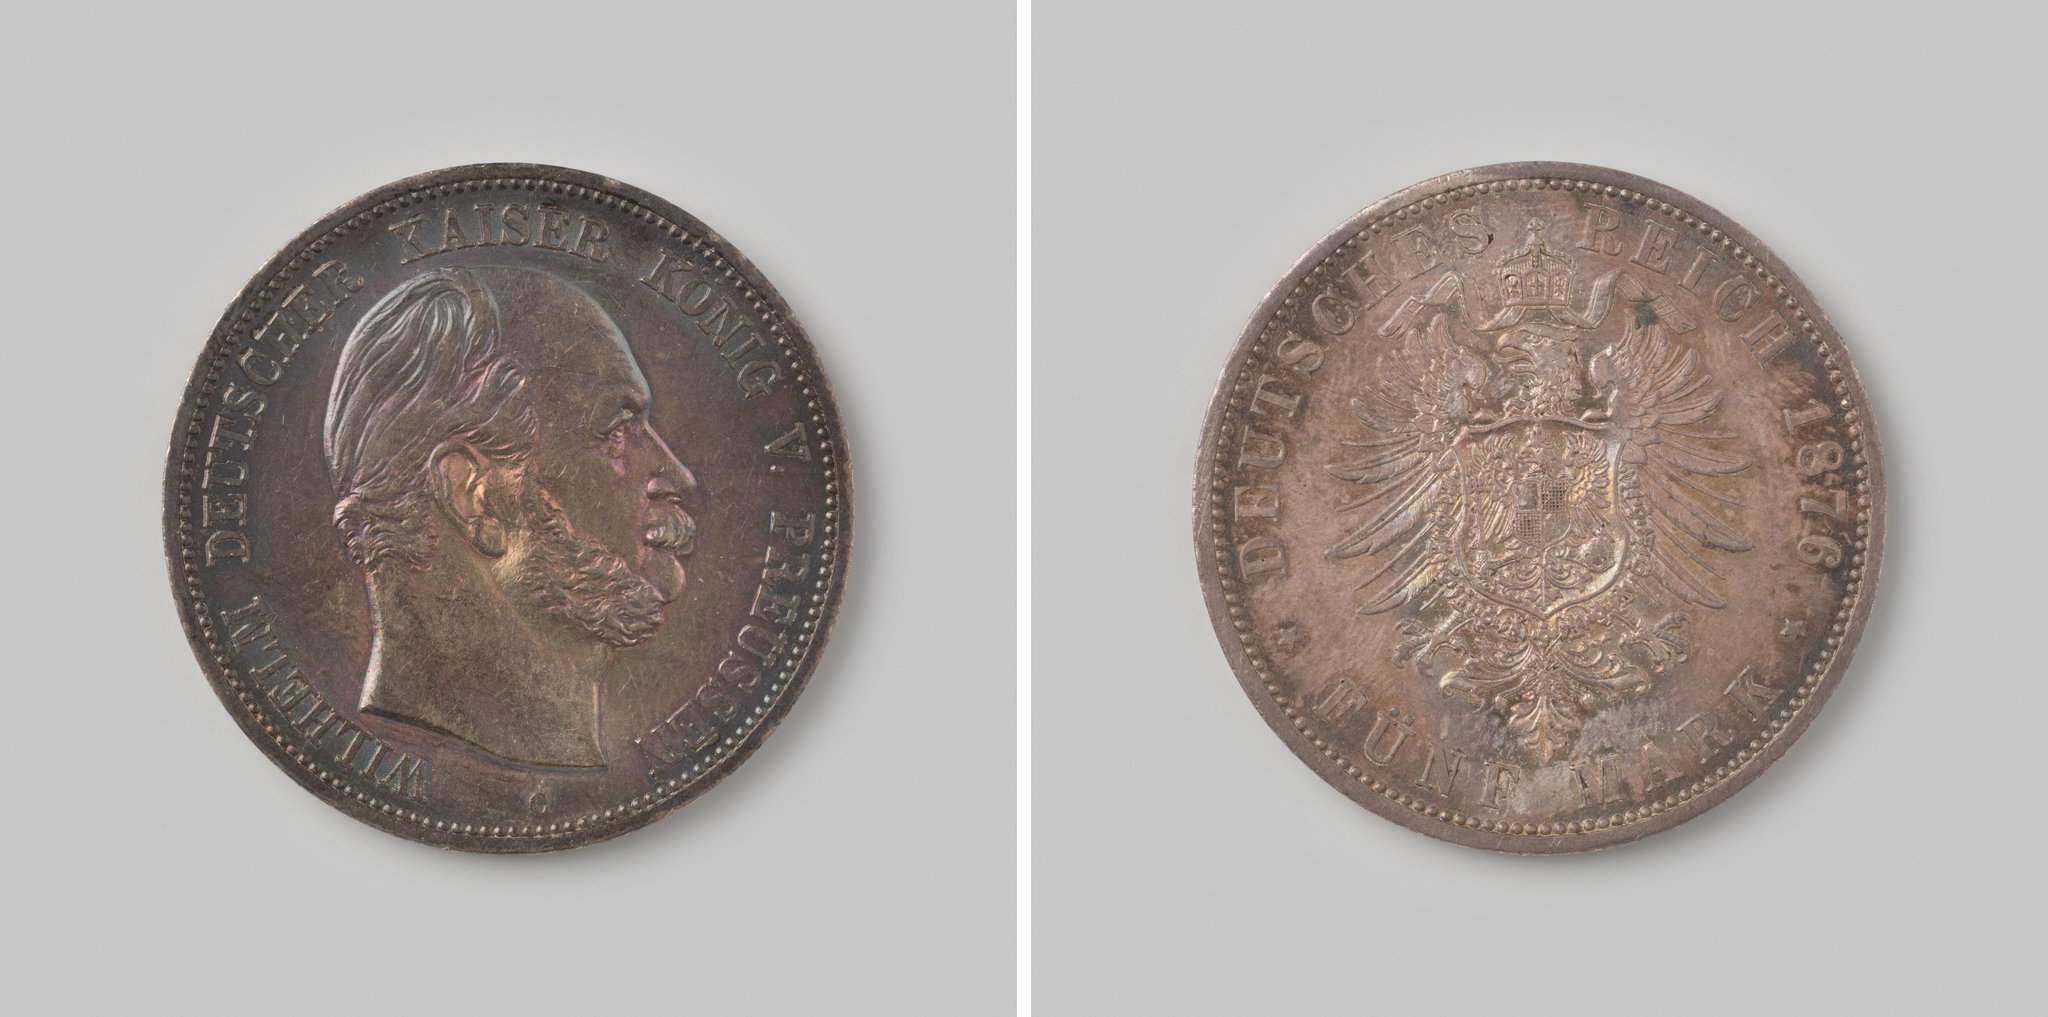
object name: vijf mark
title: Duitse Rijk, Pruisen, Wilhelm I, 5 mark, 1876 C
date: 1876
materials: silver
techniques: striking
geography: frankfurt am main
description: Zilveren munt. Voorzijde: hoofd van de keizer naar rechts. Daaronder letter C. Keerzijde: gekroonde enkelkoppige adelaar naar links met op borst door keten van orde met juweel omhangen samengesteld wapenschild. Daaronder waarde-aanduiding. Jaartal in omschrift. Randschrift.